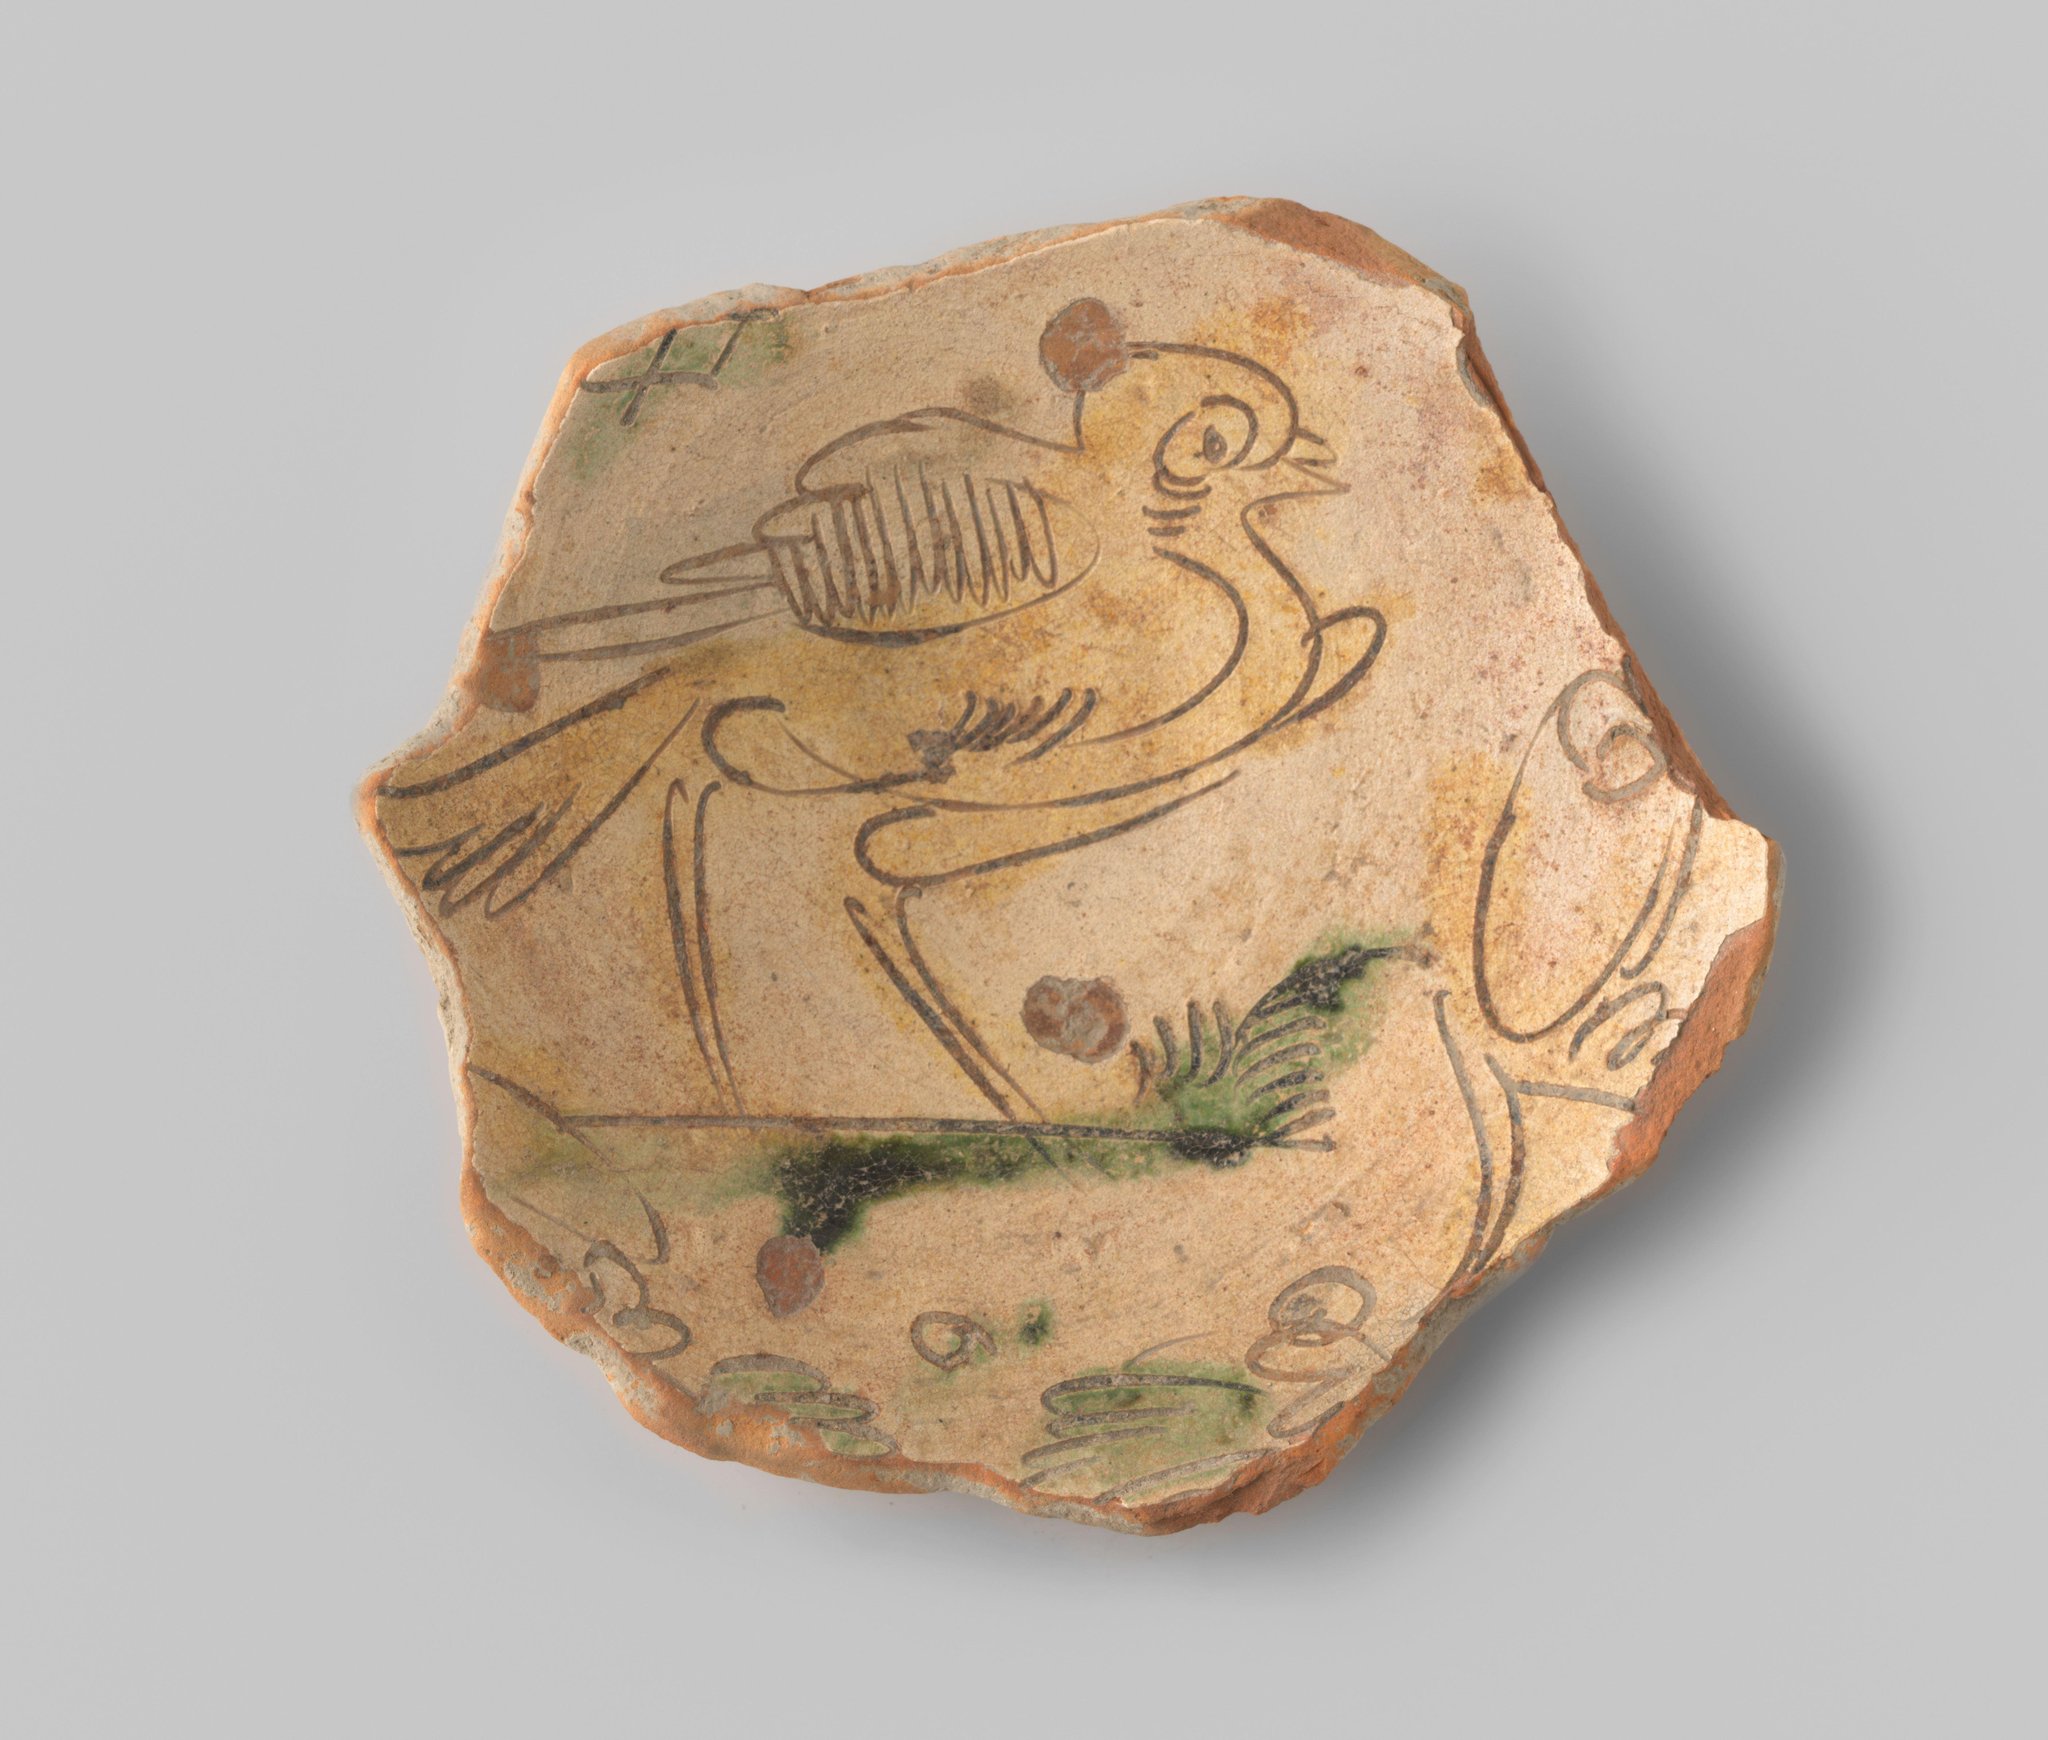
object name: sherd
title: Fragment (voet) met rode scherf, aan de binnenkant in sgraffito-techniek een vogel in oker op een groene tak, op een beige fond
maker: Anonymous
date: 1200-1899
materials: earthenware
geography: italy